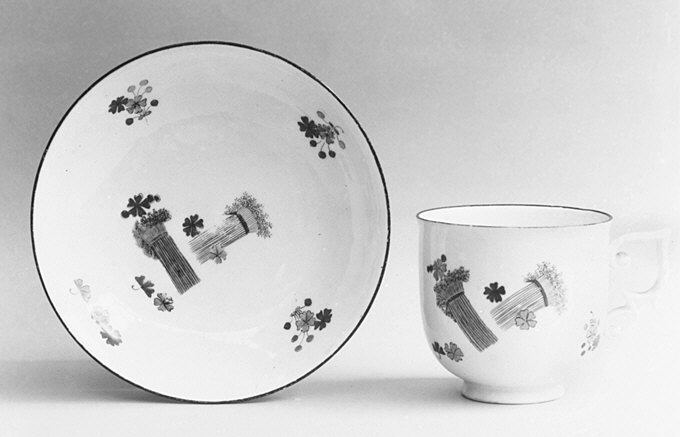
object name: cup and saucer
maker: meissen manufactory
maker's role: manufactory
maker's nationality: german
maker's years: 1710-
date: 1735-1740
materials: hard paste porcelain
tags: flowers